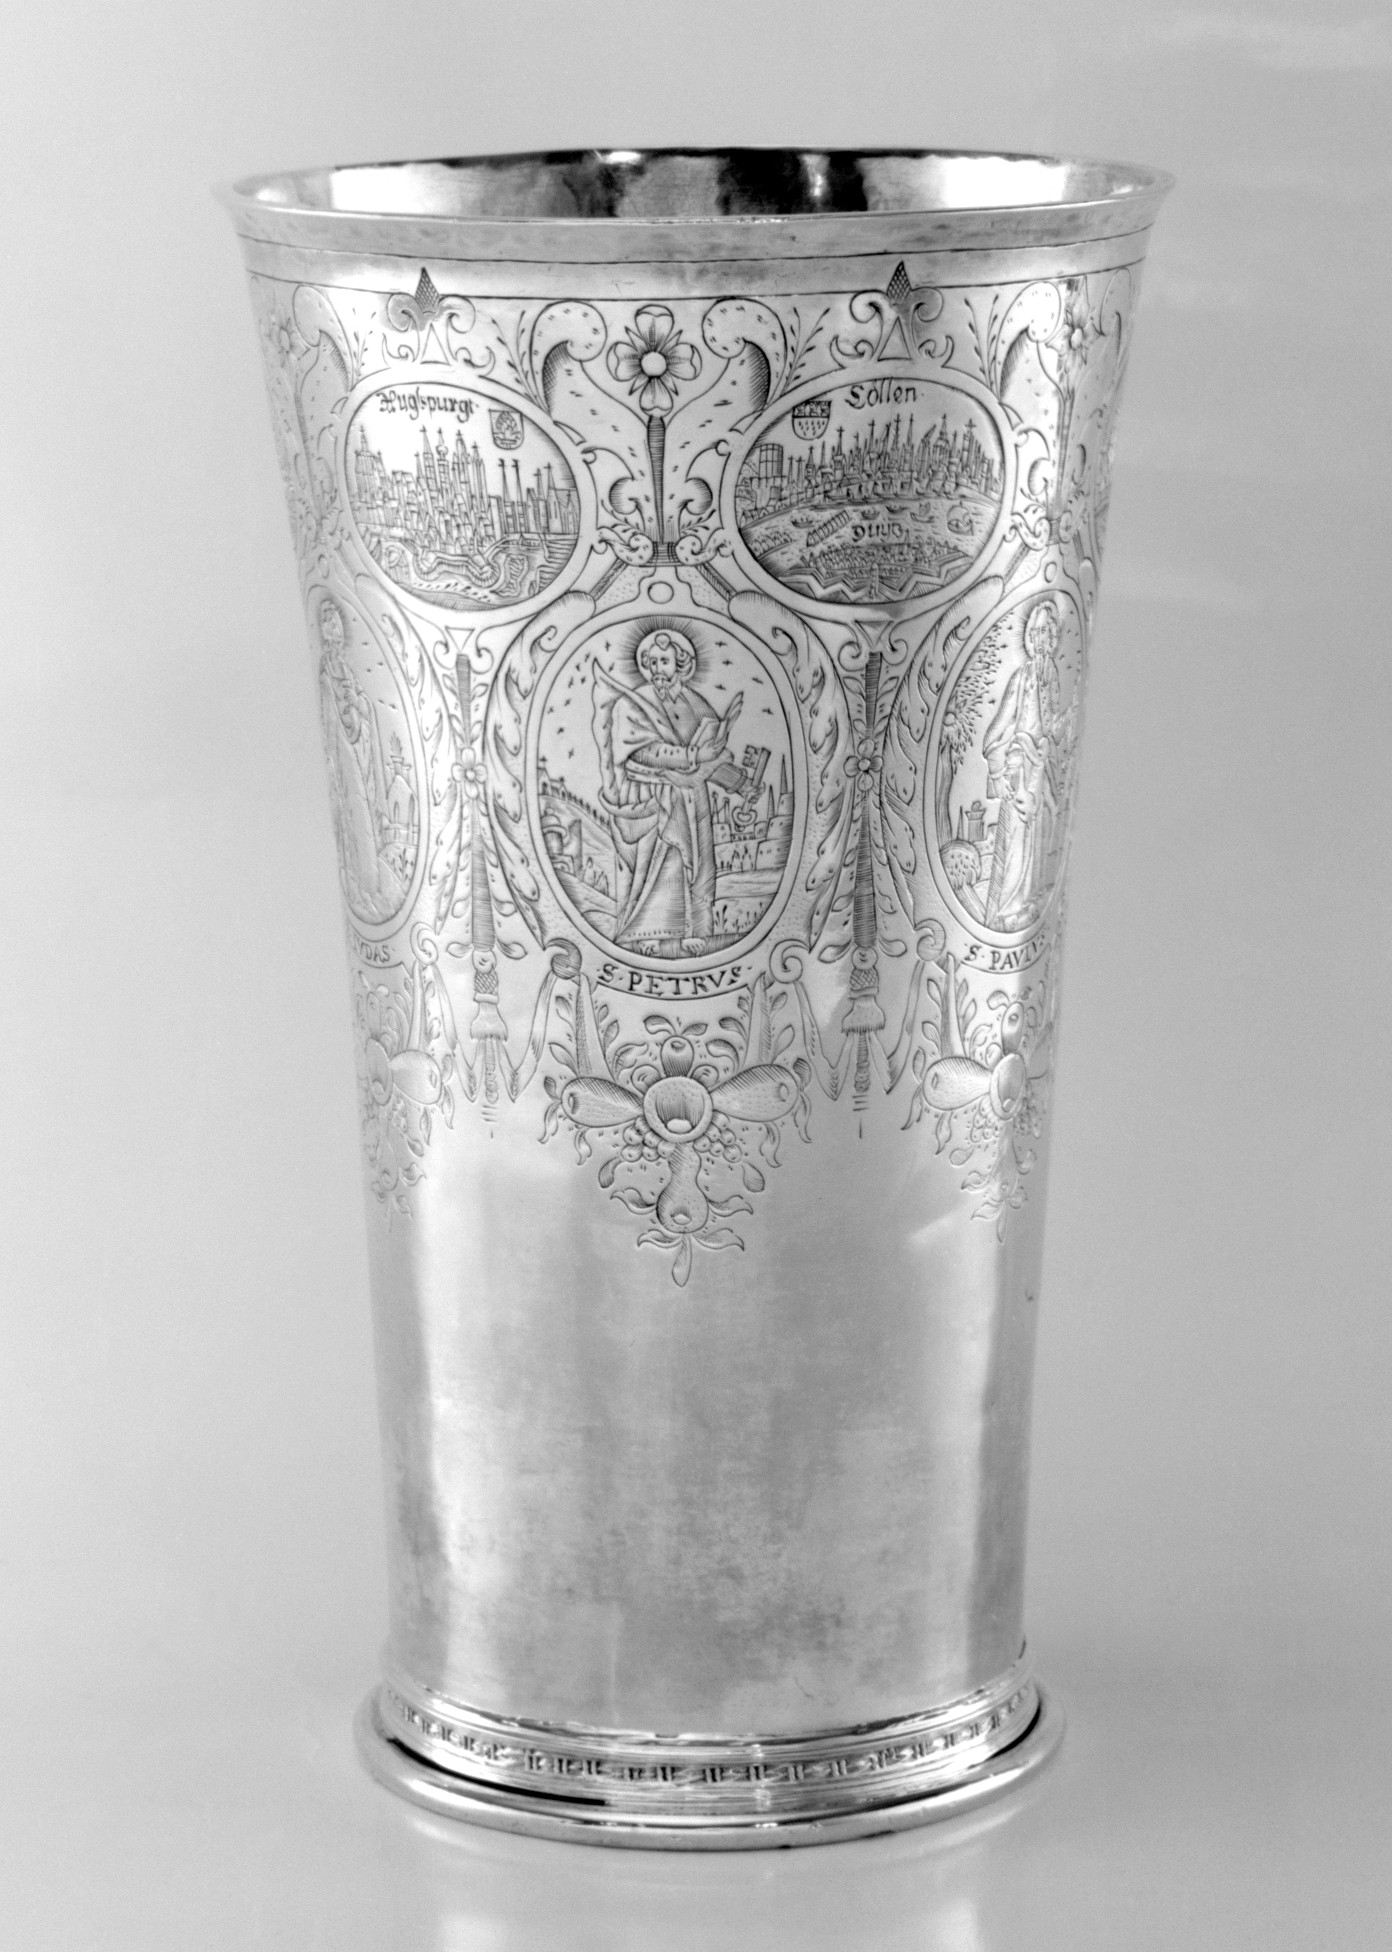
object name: beaker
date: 1601-1700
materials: silver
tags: cities,men